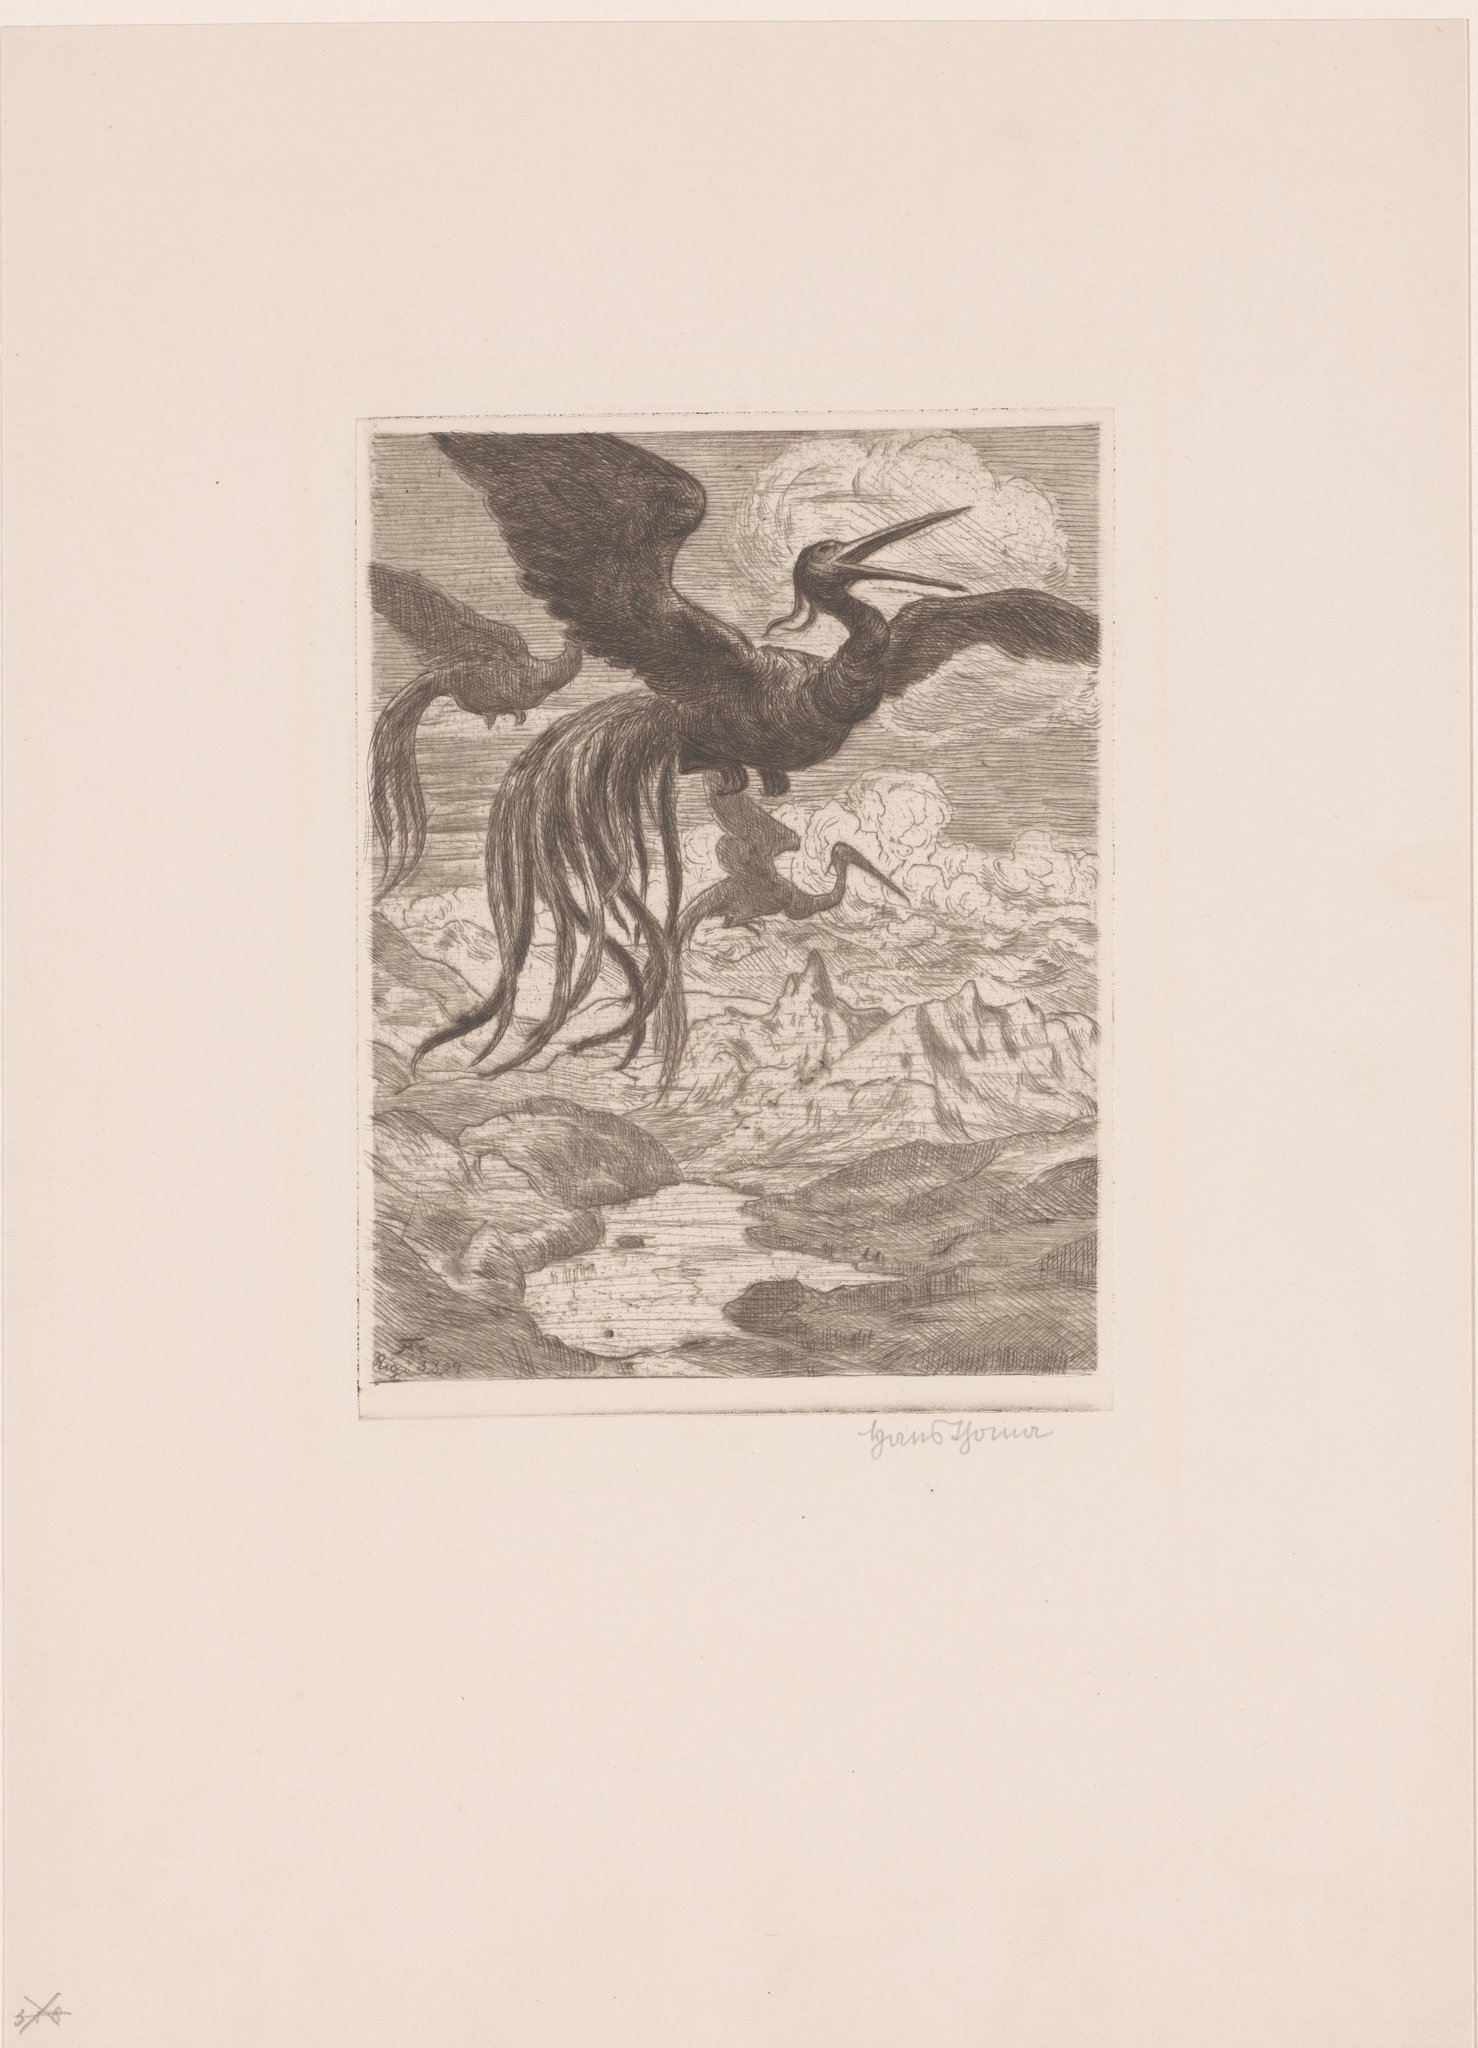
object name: print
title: Fantasie vogels boven een rivierlandschap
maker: hans thoma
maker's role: painter, print maker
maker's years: 1839-1924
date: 1904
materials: paper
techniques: drypoint, intaglio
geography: karlsruhe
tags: fabulous animals ~ birds, river, landscapes with waters, waterscapes, seascapes (in the temperate zone), mountains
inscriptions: collector's mark: Lugt 2228